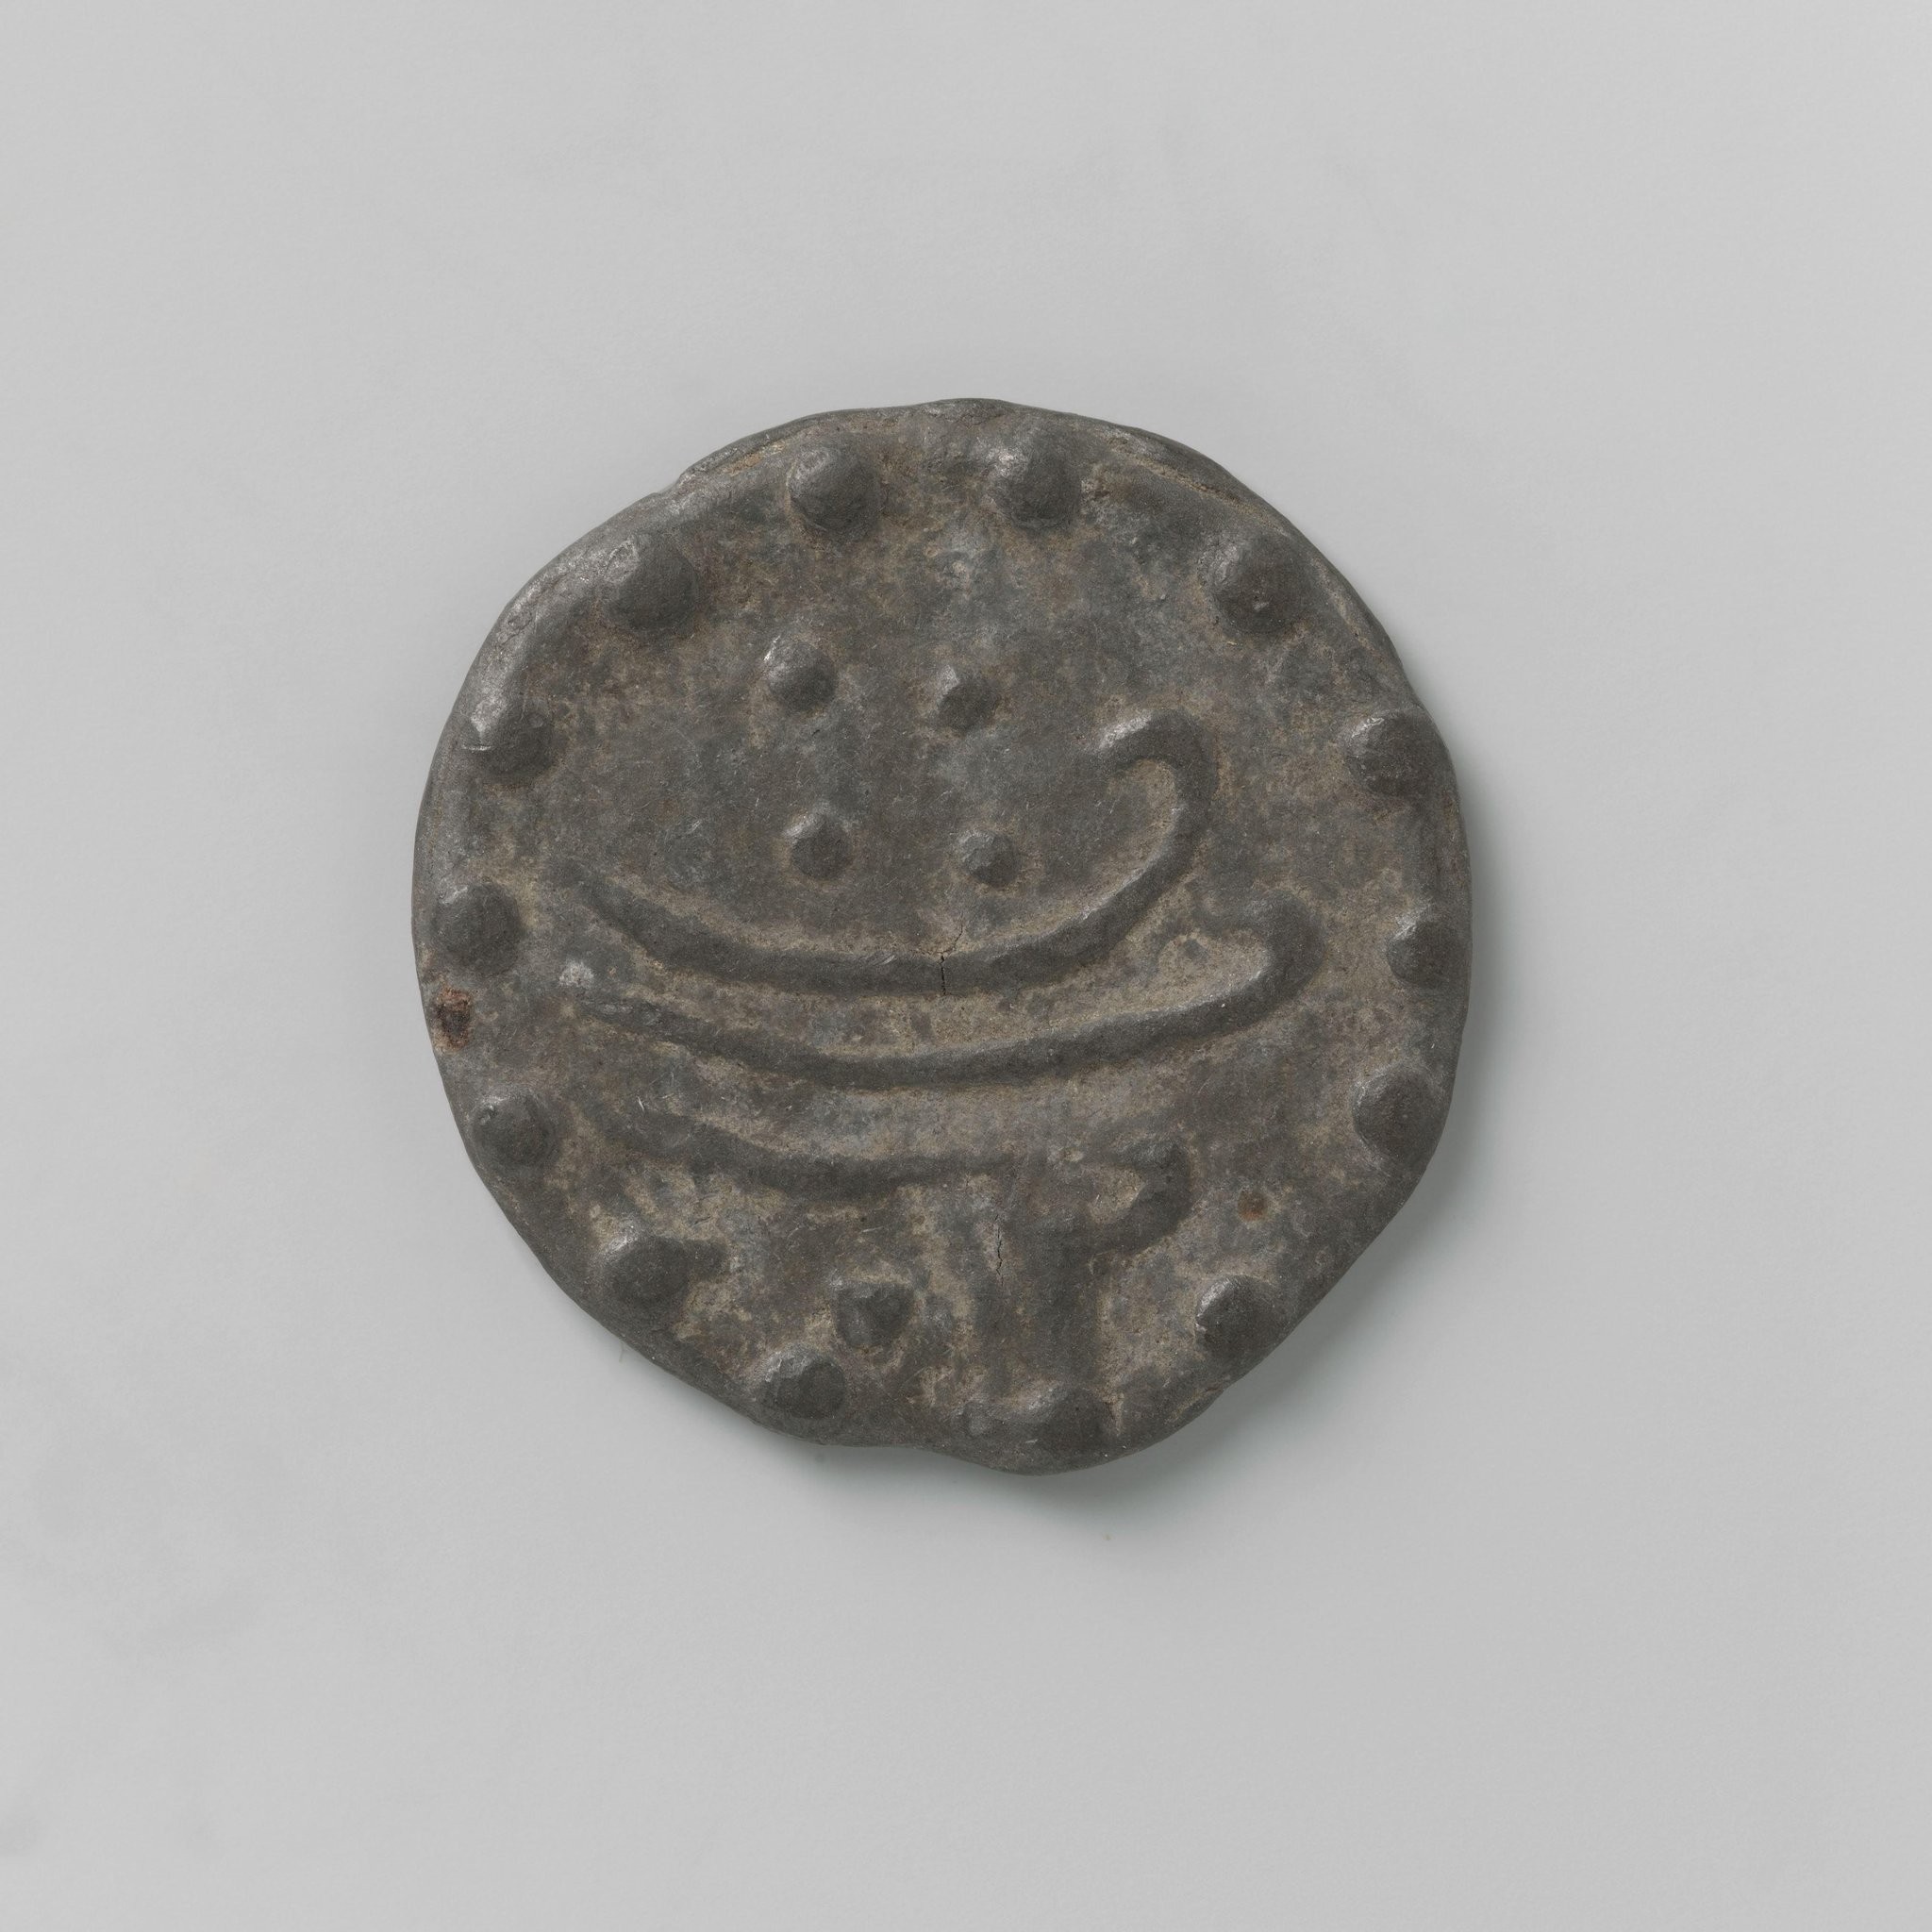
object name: coin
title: Kasja van sultan Mohammed van Atjeh, Sumatra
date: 1824-1838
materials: tin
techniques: casting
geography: aceh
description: Tinnen munt. Voorzijde: drieregelig opschrift in Arabische lettertekens. Keerzijde: drieregelig opschrift in Arabische lettertekens.